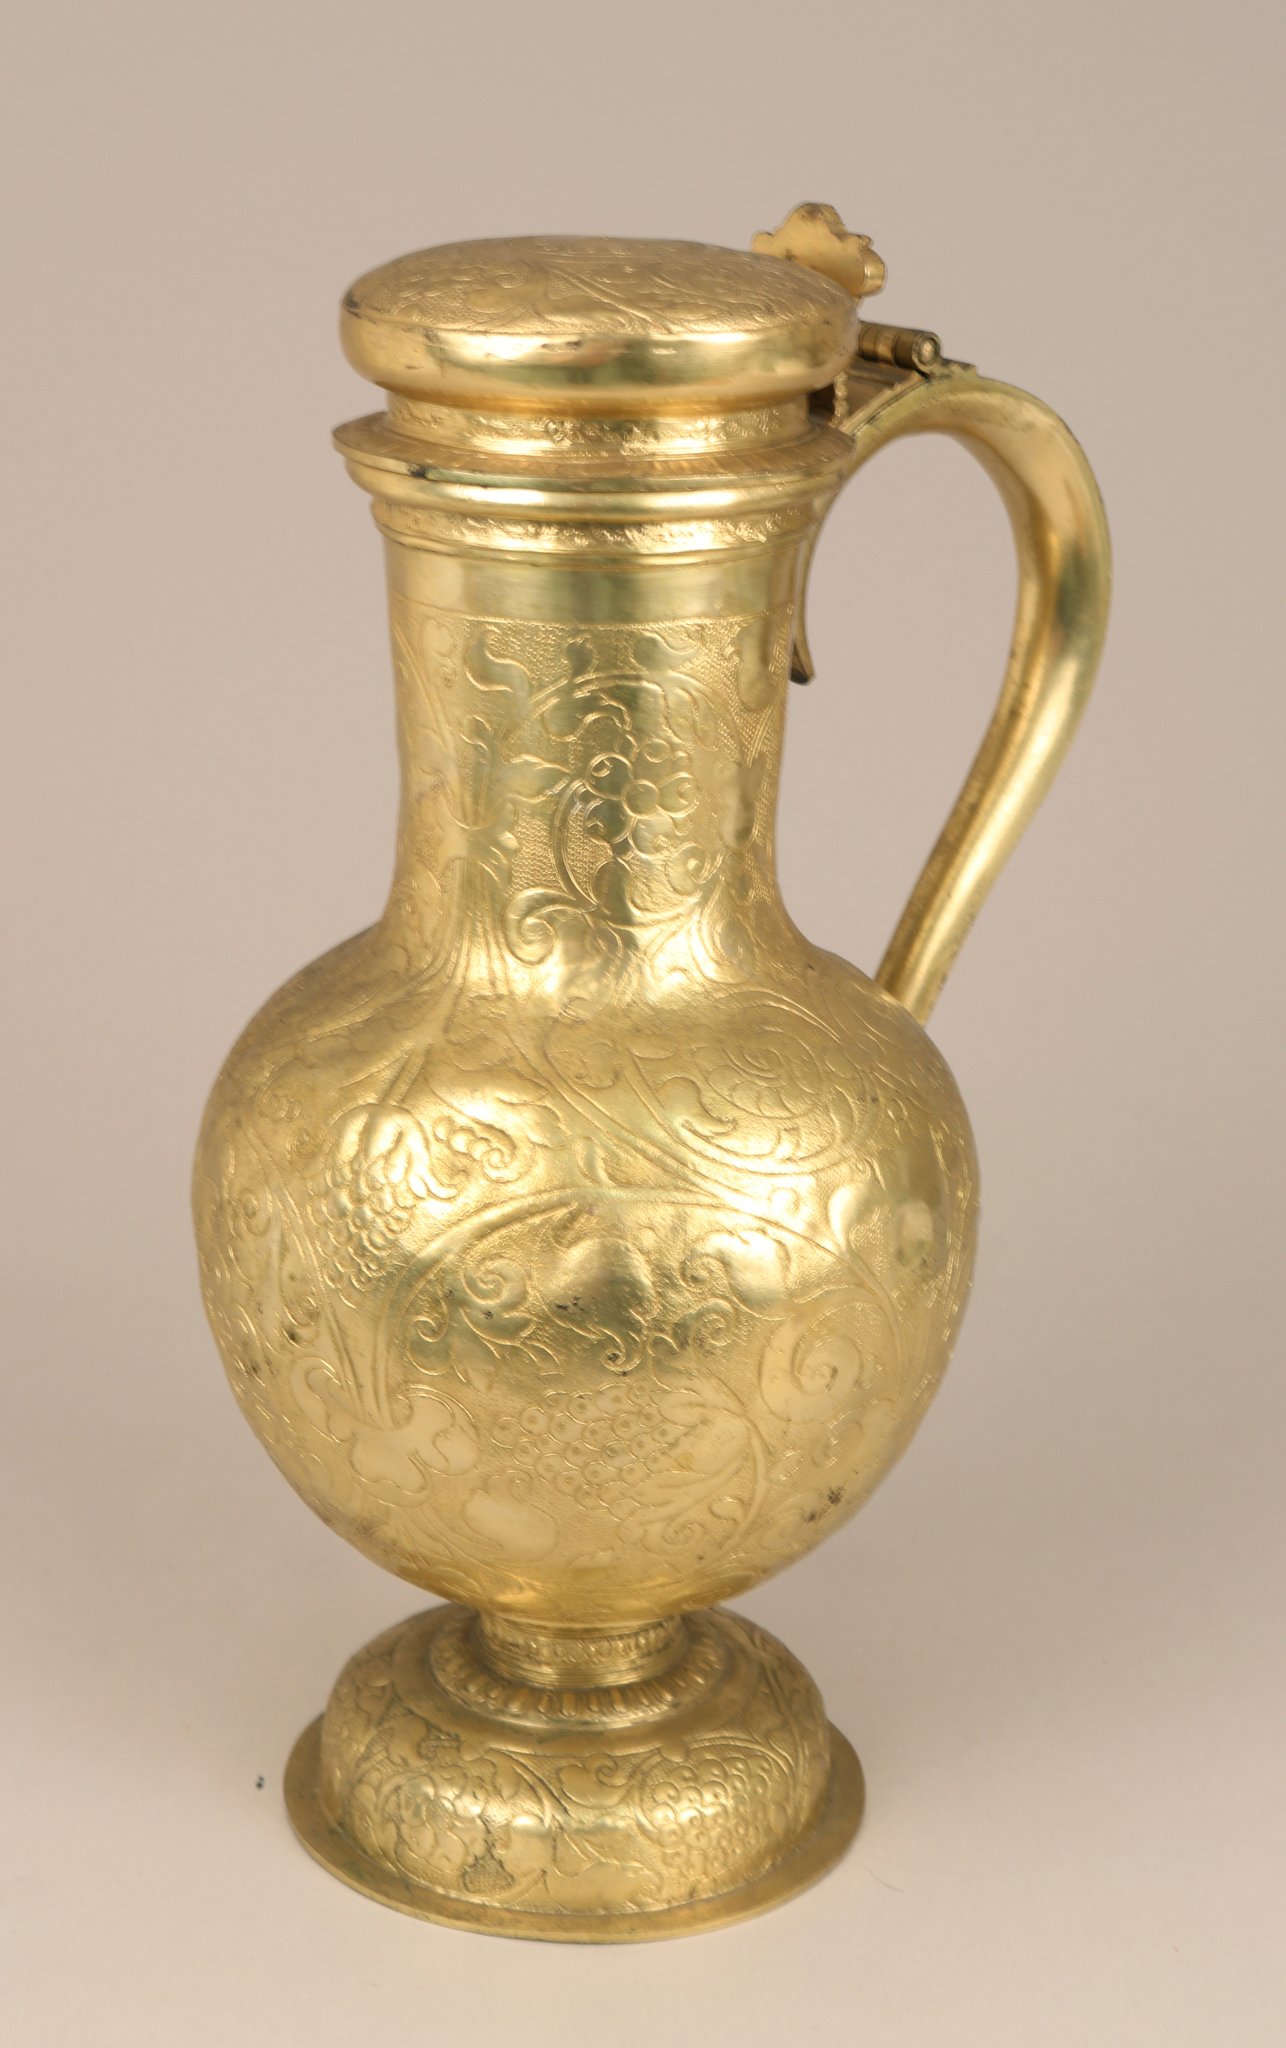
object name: flagon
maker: elkington & co.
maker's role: manufacturer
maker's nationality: british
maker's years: 1829-1963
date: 1801-1900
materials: metal, silver